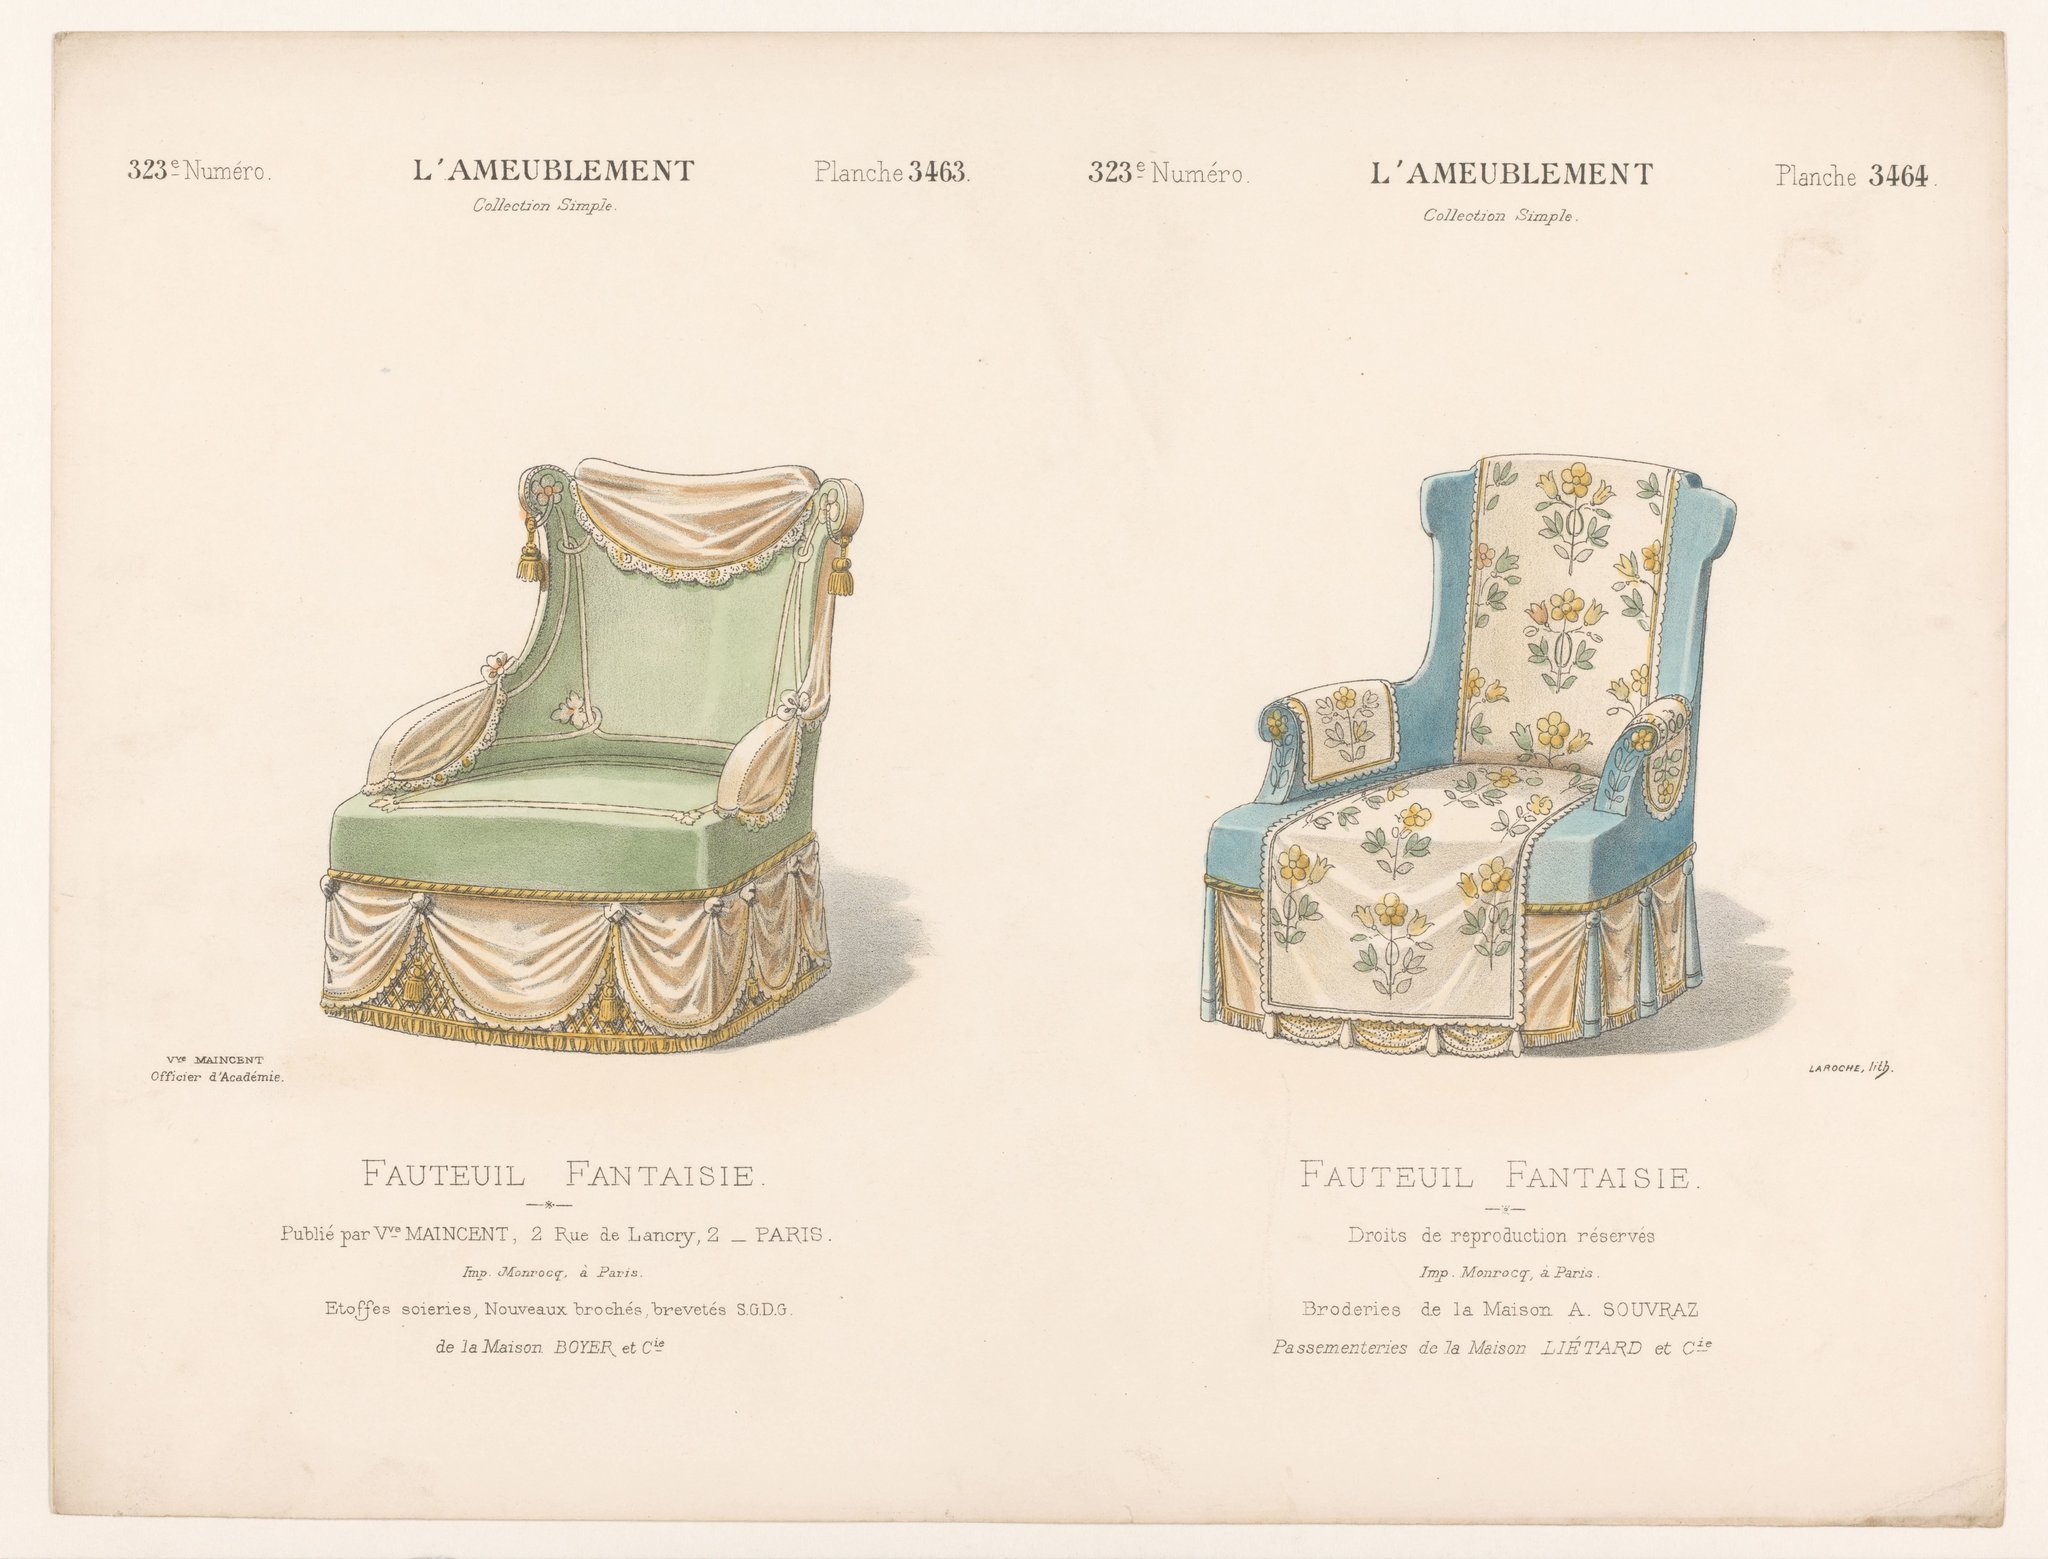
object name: print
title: Twee fauteuils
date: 1895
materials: paper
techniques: hand coloring, lithograph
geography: paris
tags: seating furniture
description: Twee fauteuils. Prent uit 323e nummer (livraison).